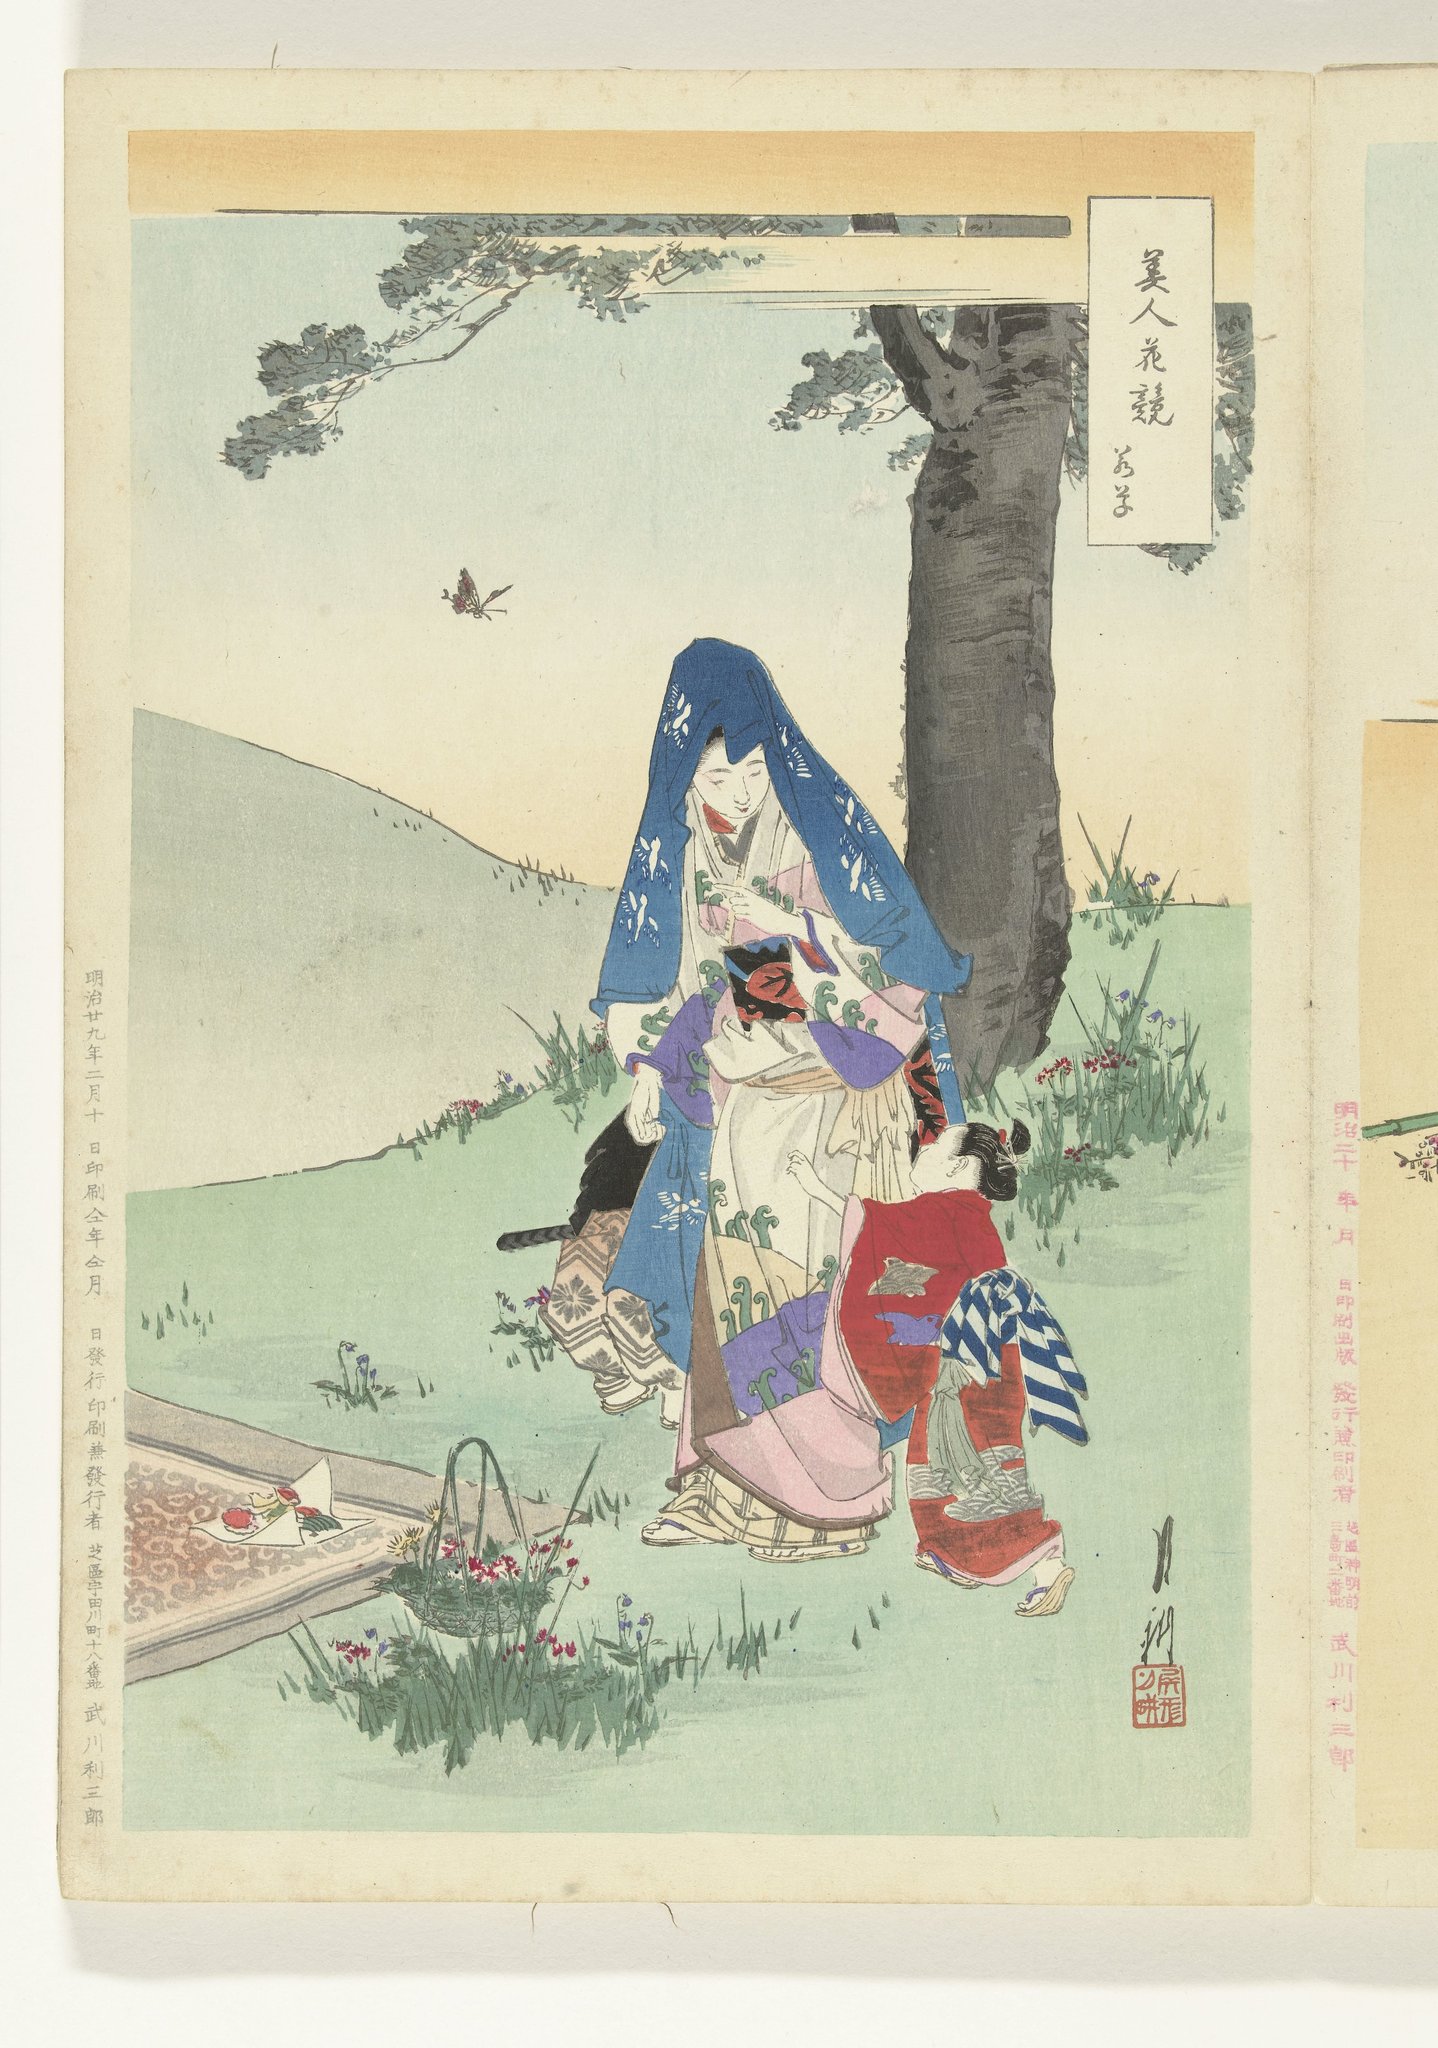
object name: print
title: Bijin hana kurabe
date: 1896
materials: paper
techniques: blind stamped, woodcut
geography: japan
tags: trees, picnic, alfresco, 'déjeuner sur l'herbe', mother and child(ren), woman and child(ren) (family group)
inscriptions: collector's mark: Lugt 2760, collector's mark: Lugt 2228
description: Vrouw en kind onder een boom; op de voorgrond een mandje met bloemen en een picknickkleed.